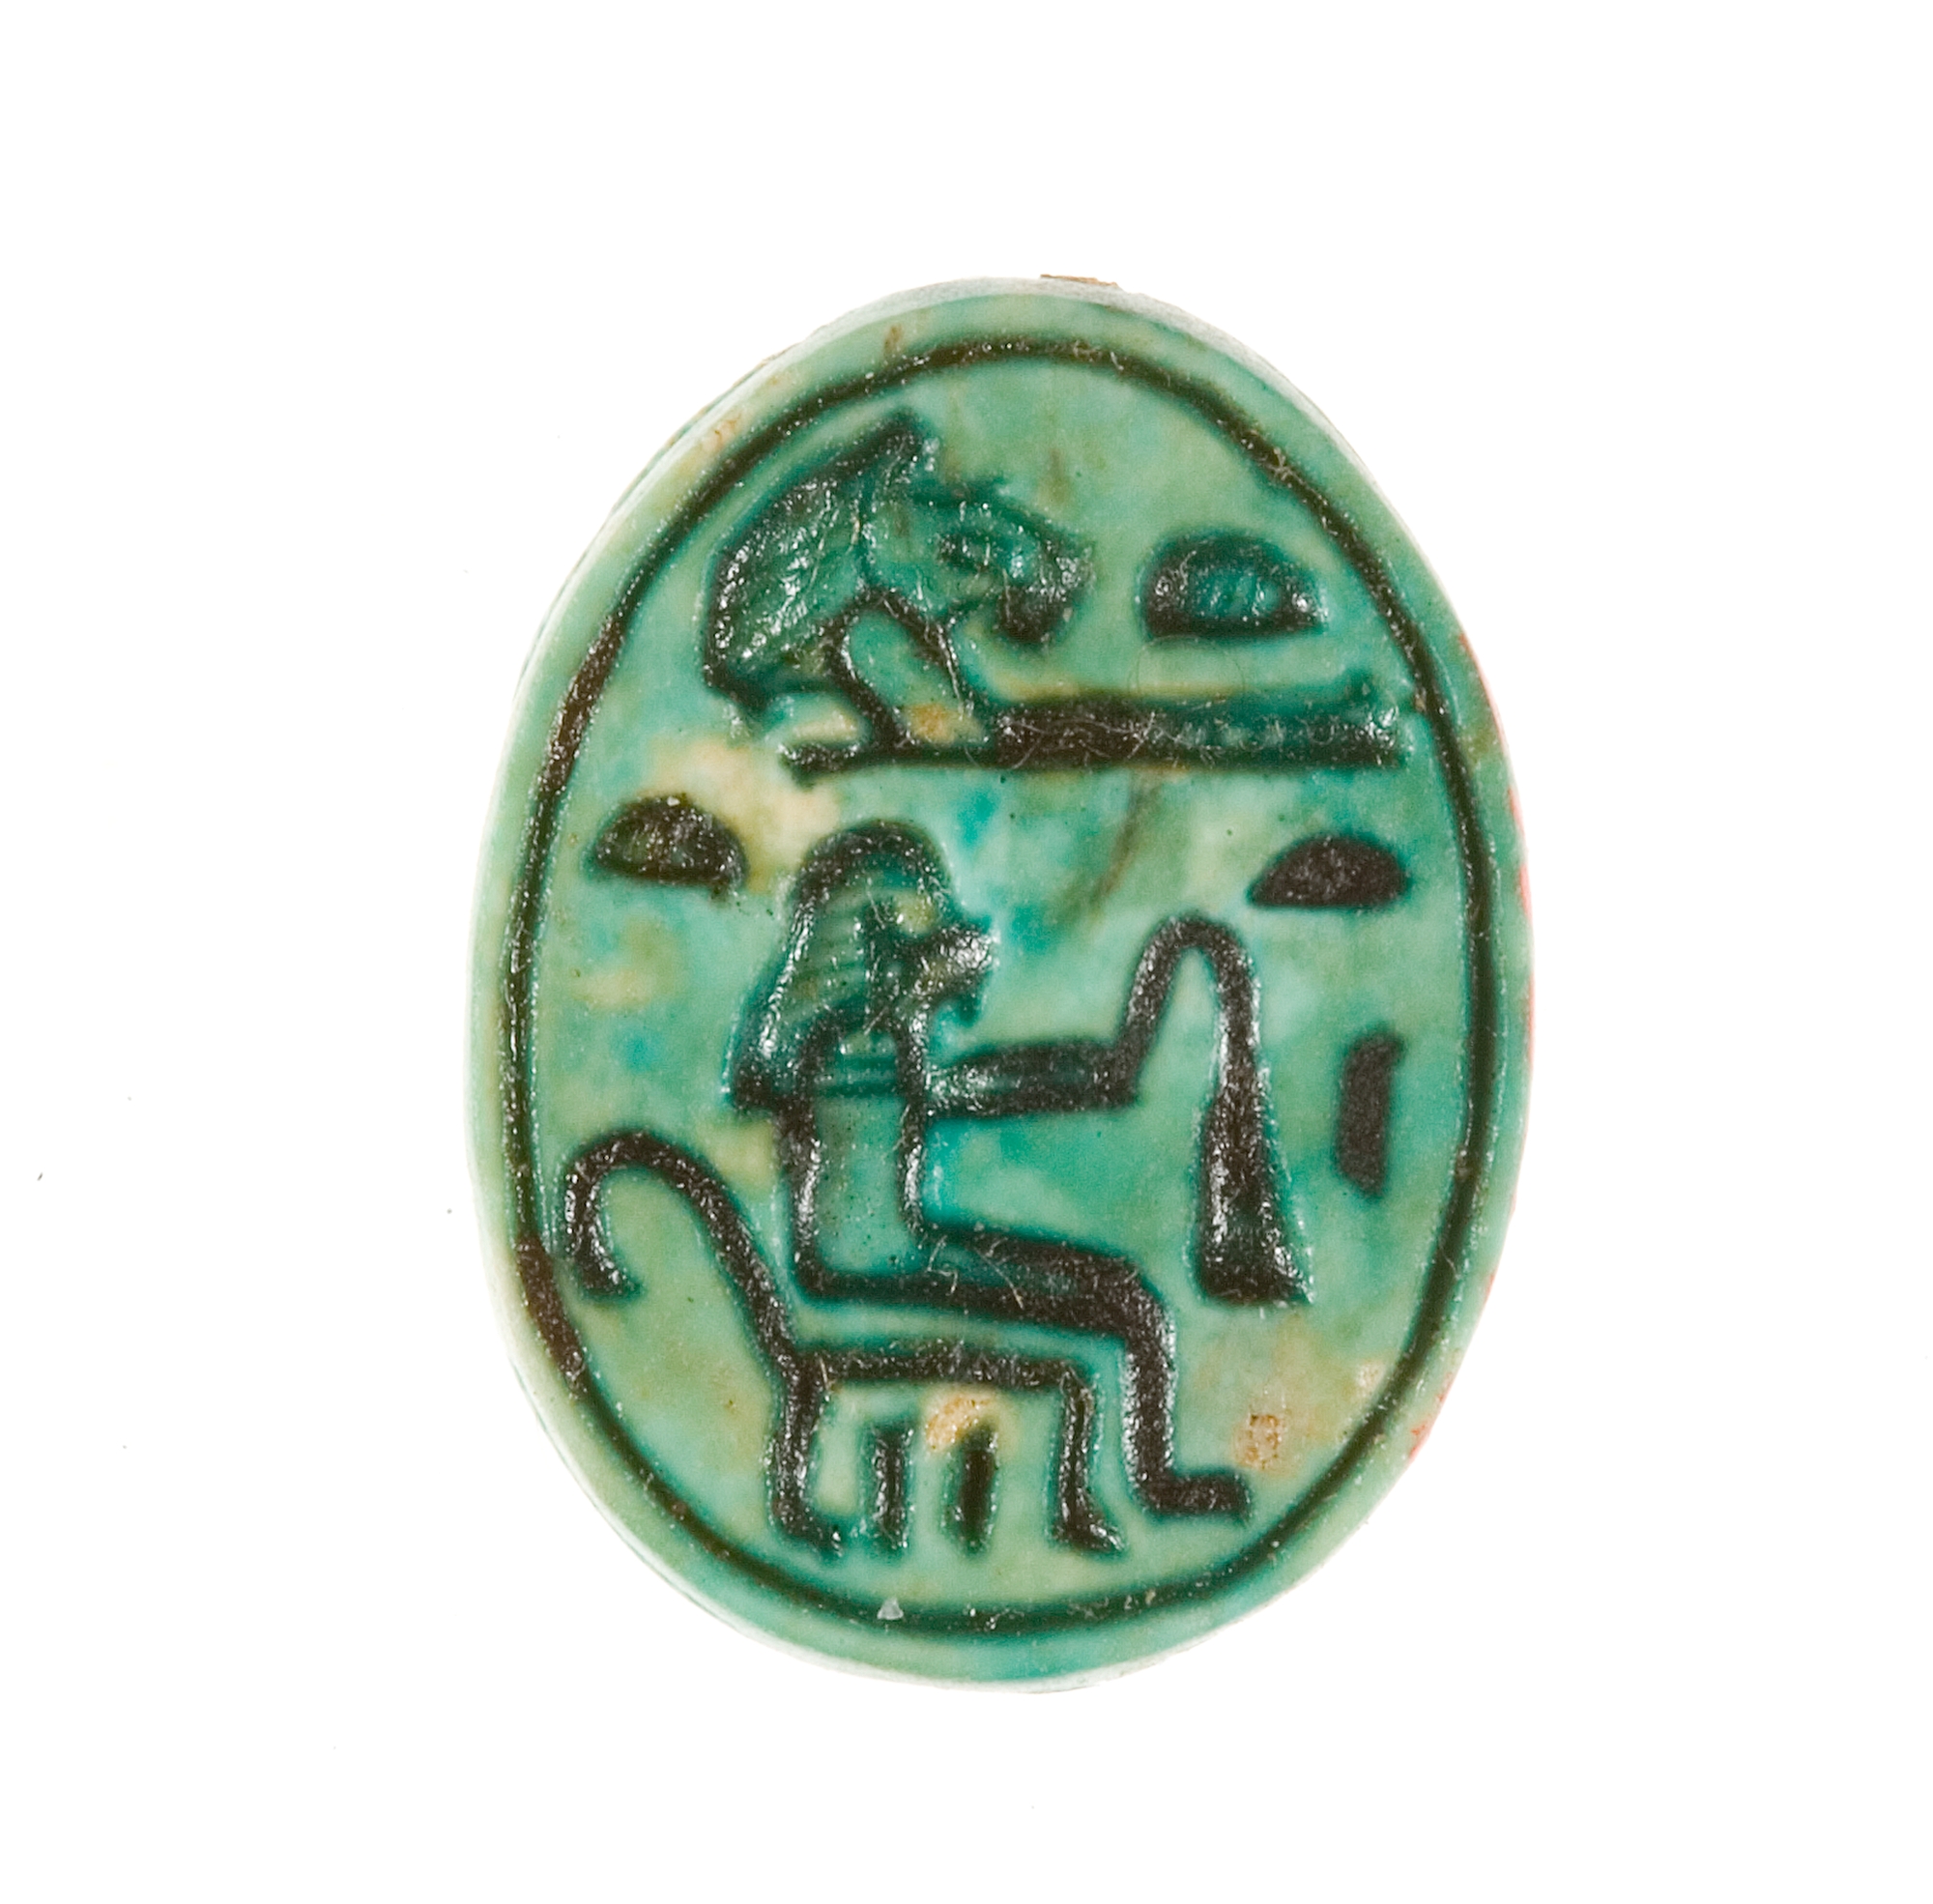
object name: scarab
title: Scarab Inscribed for Hatshepsut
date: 1479-1458 BCE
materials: stone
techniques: glazing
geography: egypt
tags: hieroglyphs,scarabs